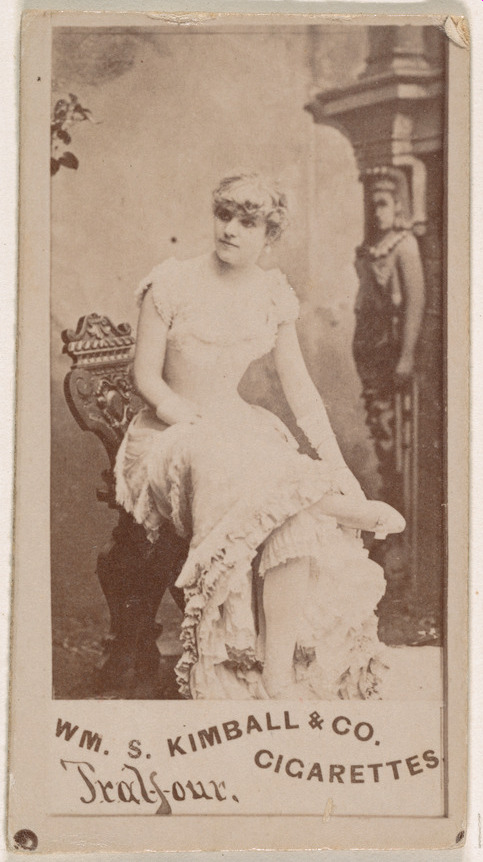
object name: photograph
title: Miss Tralfour, from the Actresses series (N203) issued by Wm. S. Kimball & Co.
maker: william s. kimball & company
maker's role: publisher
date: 1889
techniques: color lithograph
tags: portraits,women,actresses